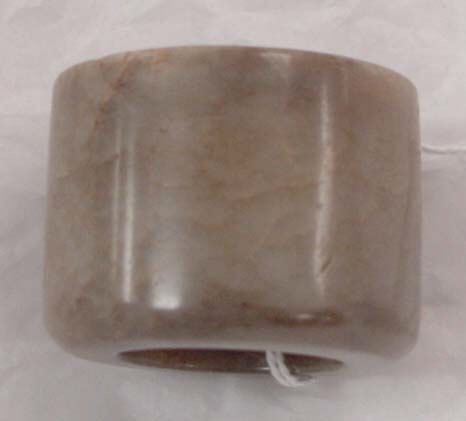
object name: ring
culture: chinese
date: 1801-1900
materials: jade